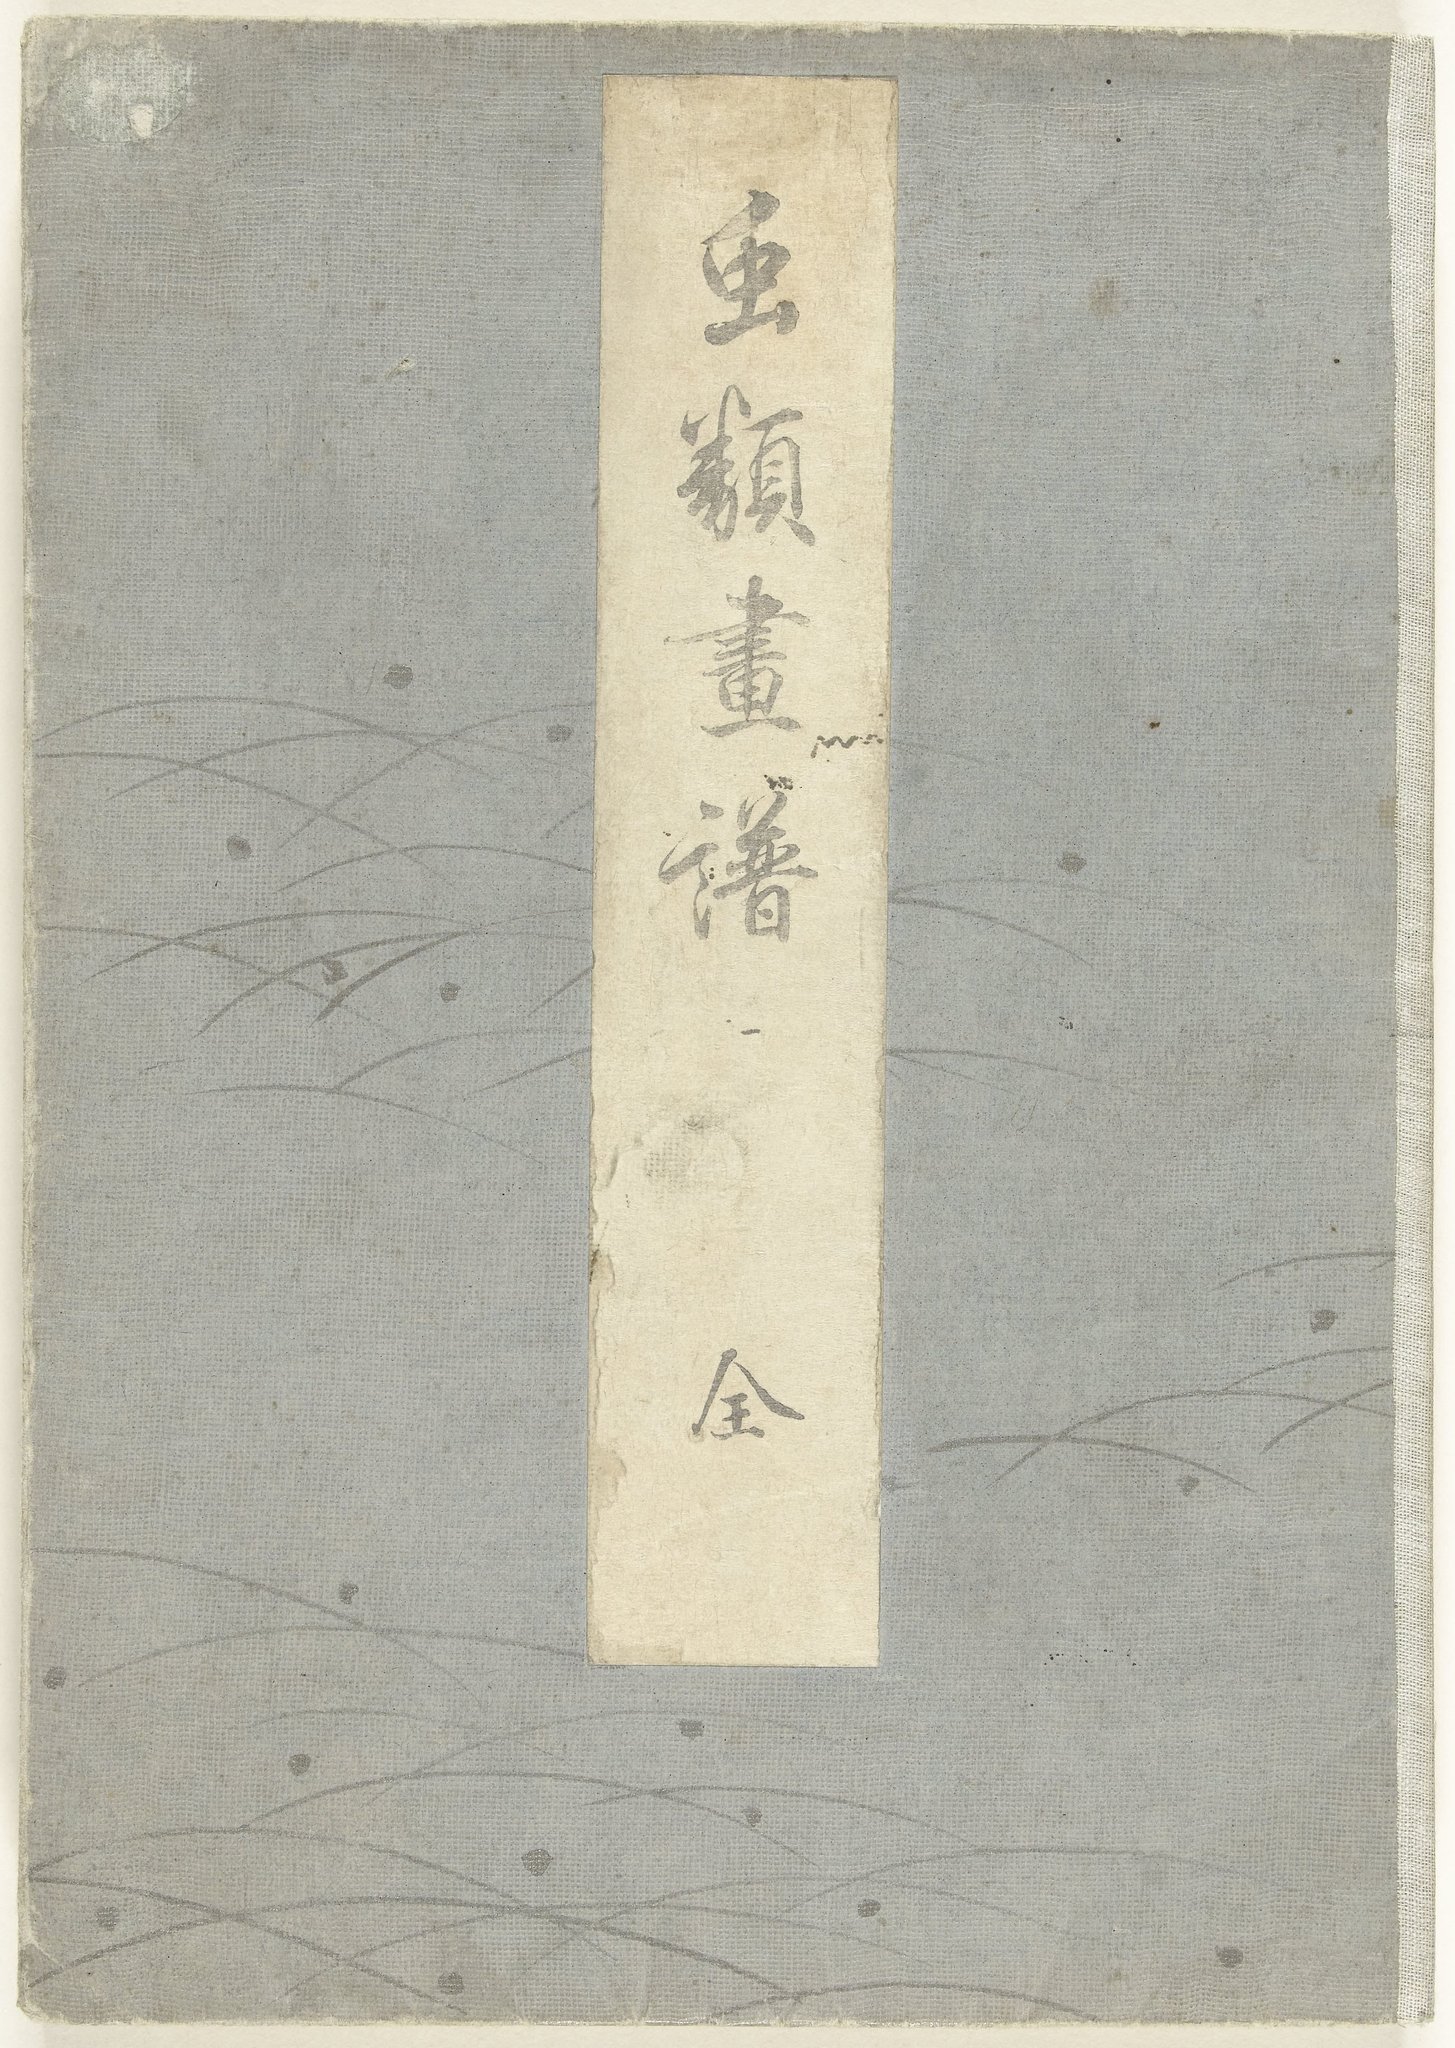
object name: book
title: Churui gafu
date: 1892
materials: paper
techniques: woodcut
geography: tokyo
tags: flowers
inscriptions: collector's mark: Lugt 2228, collector's mark: Lugt 2166